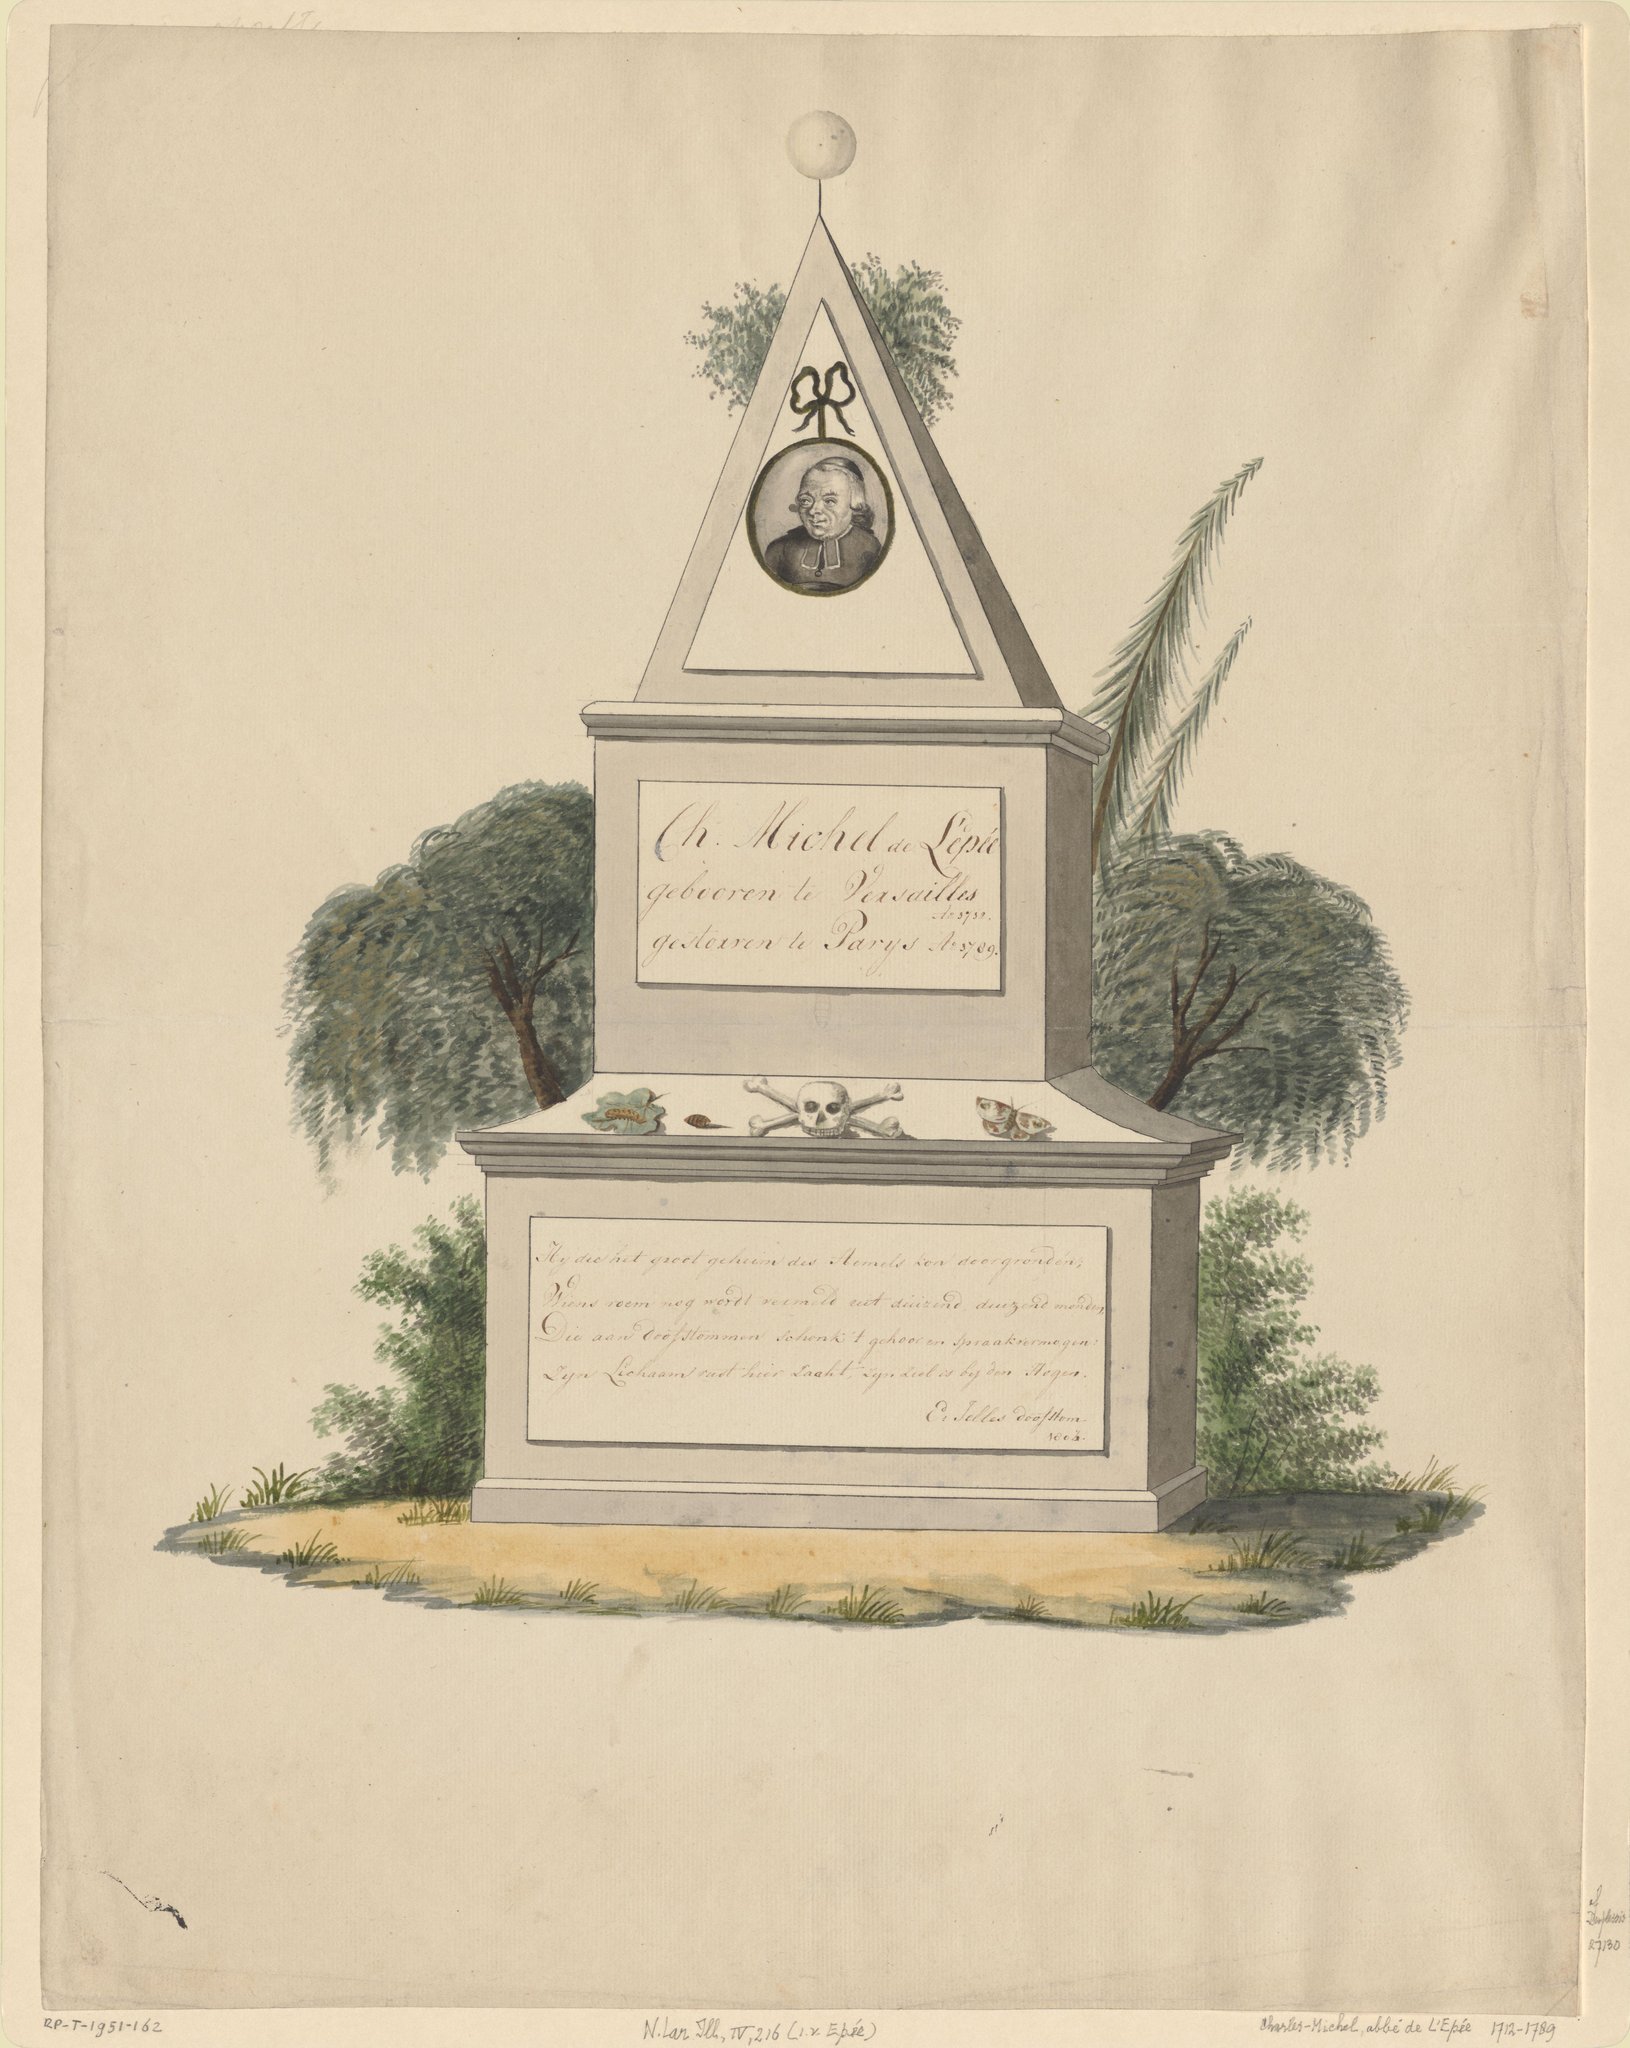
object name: print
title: Grafmonument met portret van Charles-Michel de l'Epée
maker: eelke jelles eelkema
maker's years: 1788-1839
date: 1804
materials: ink, paper, watercolor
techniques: brush, pen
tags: scholar, philosopher, historical persons, grave-building, monumental tomb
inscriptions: collector's mark: Lugt 2228